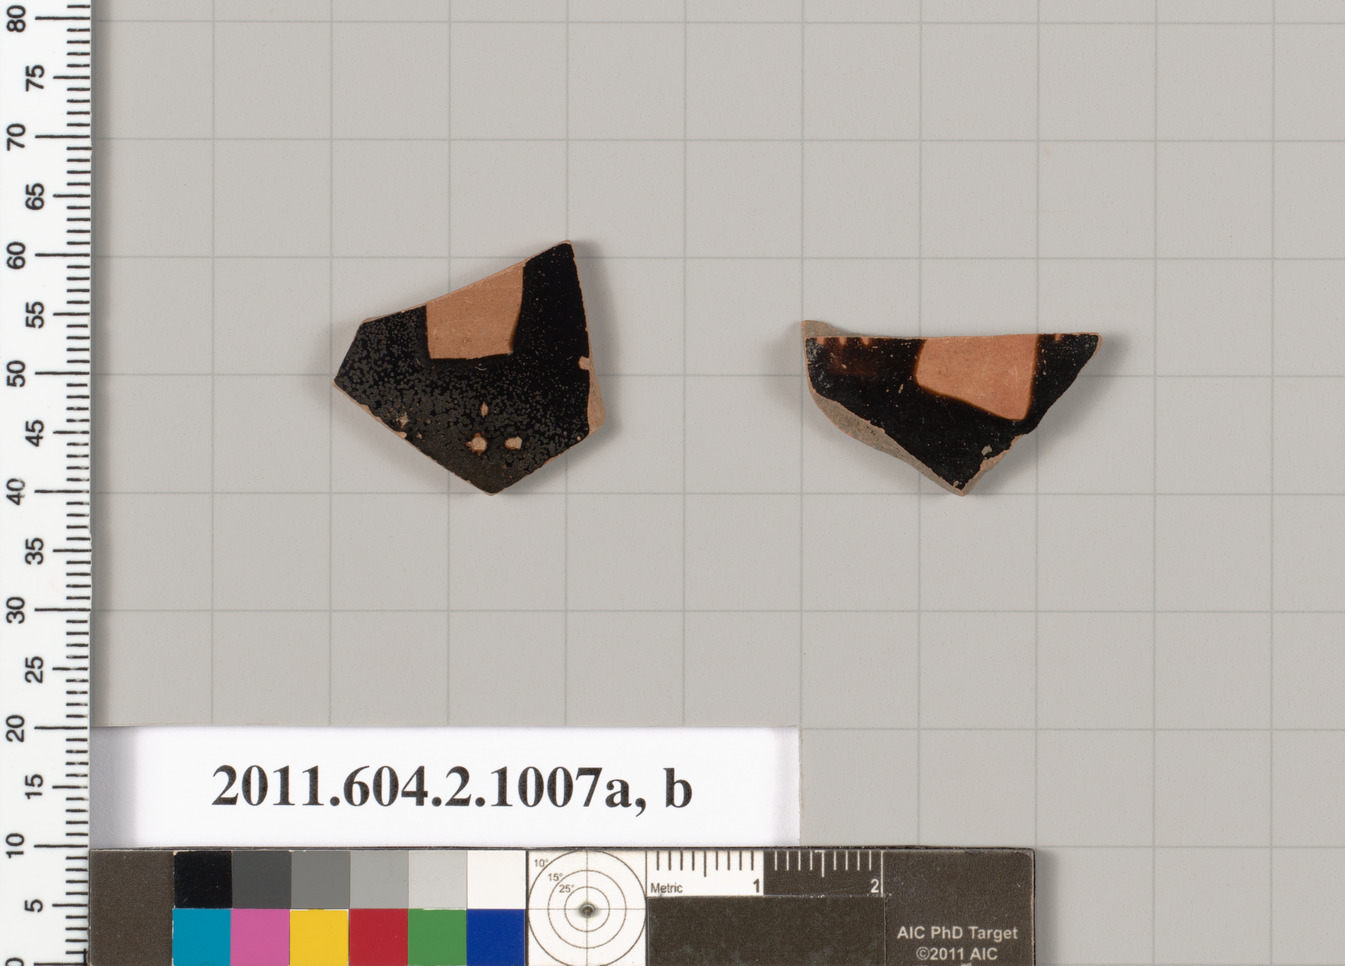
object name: oinochoe fragment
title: Terracotta fragments of oinochoai (jugs)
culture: greek, attic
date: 467-435 BCE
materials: terracotta